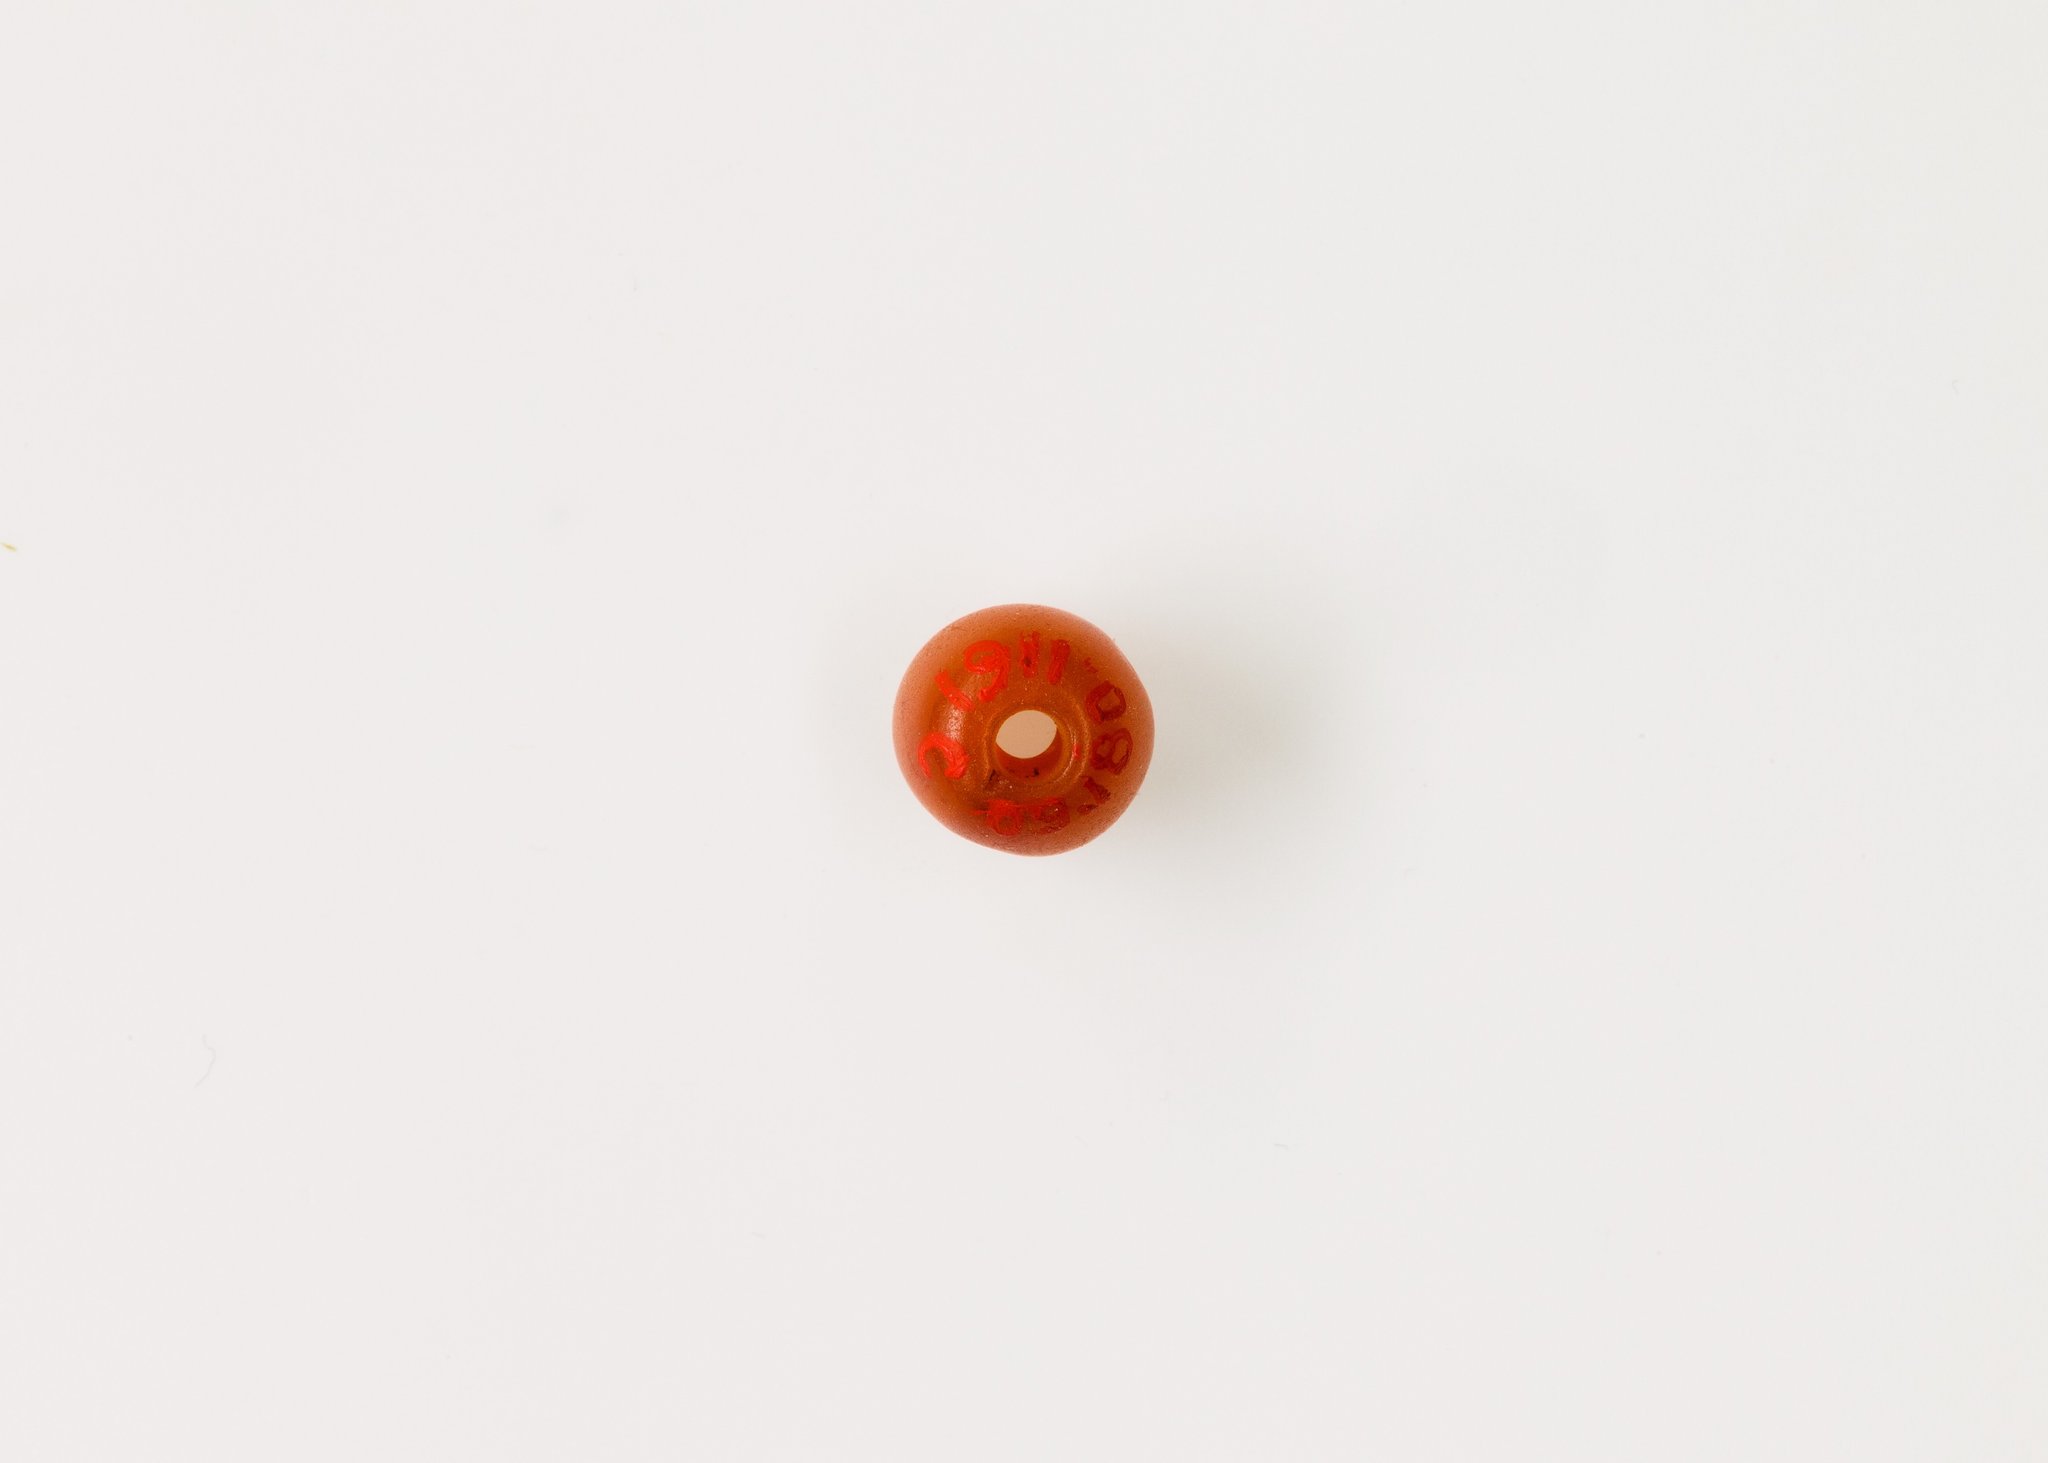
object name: bead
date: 1981-1550 BCE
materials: gemstone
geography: egypt